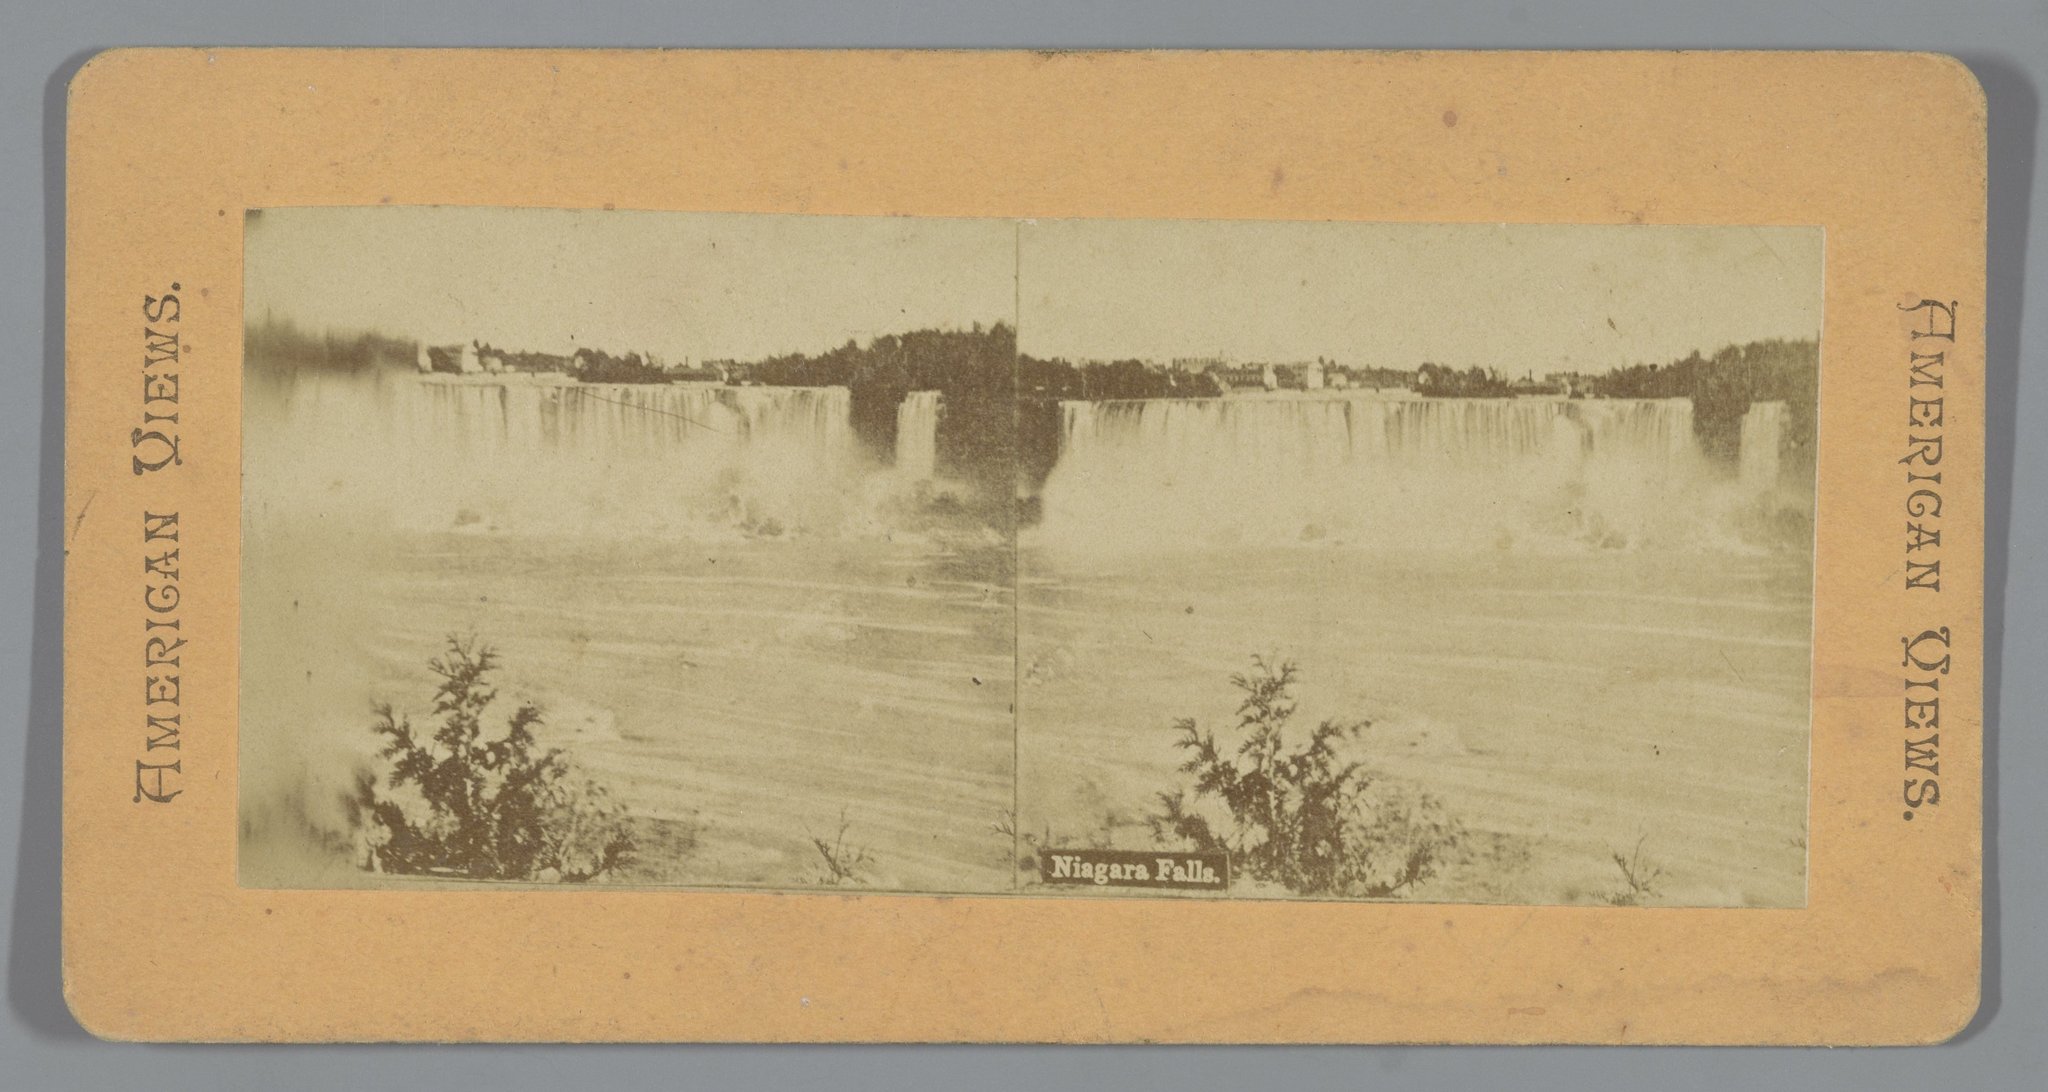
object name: stereograph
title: American Views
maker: Anonymous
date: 1873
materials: cardboard, paper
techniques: albumen print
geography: niagara falls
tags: waterfall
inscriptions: inscription: ‘[...] 1873/ 8’